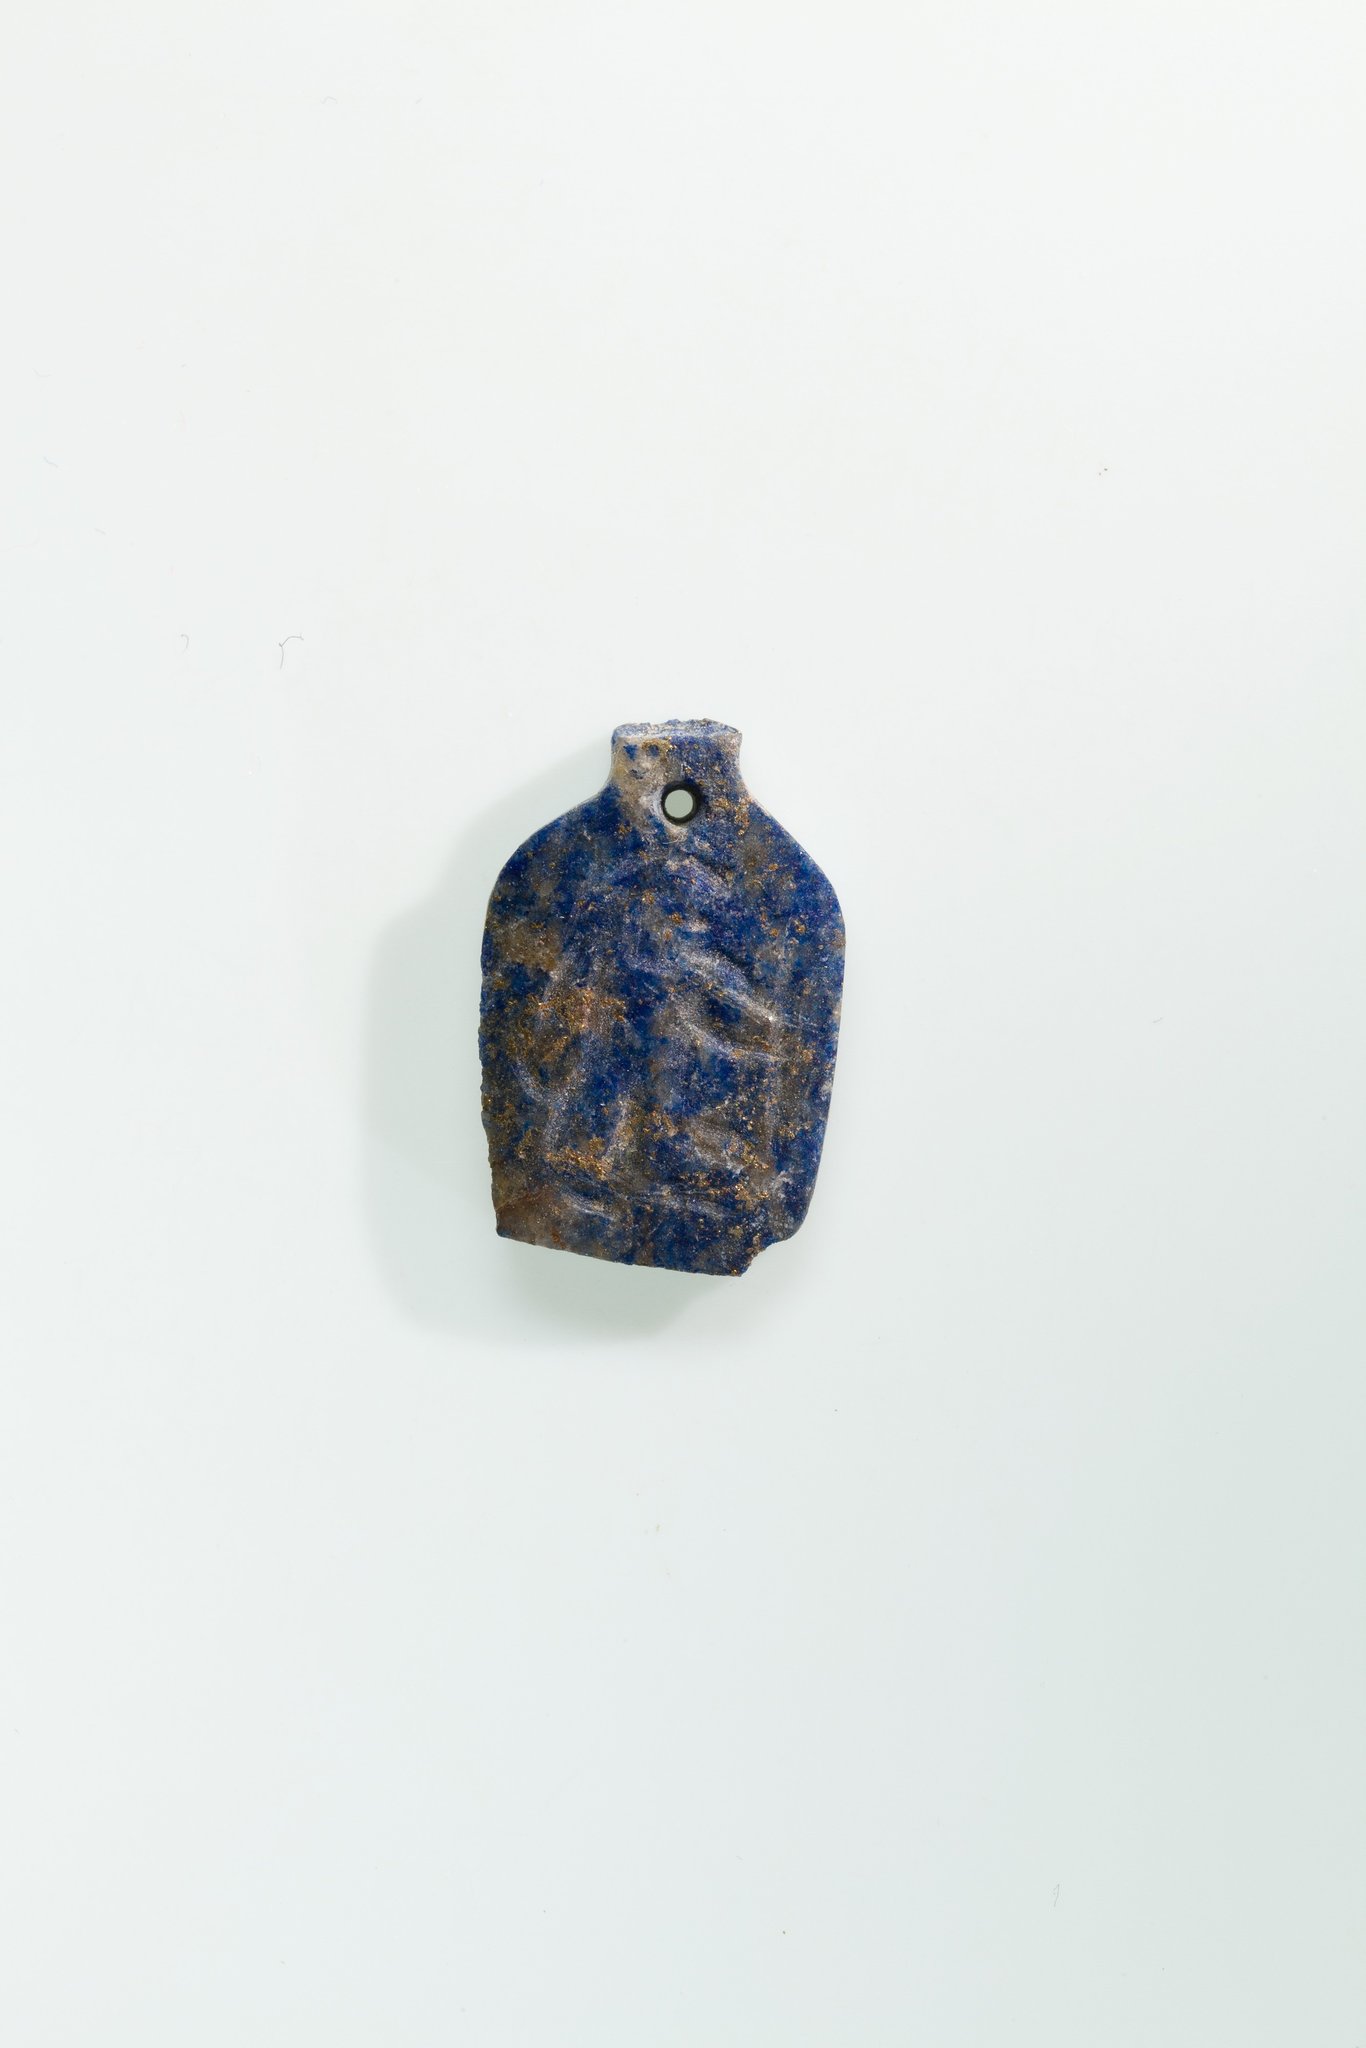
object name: amulet plaque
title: Plaque with a striding man from string of amulets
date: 1070-945 BCE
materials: lapis lazuli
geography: egypt